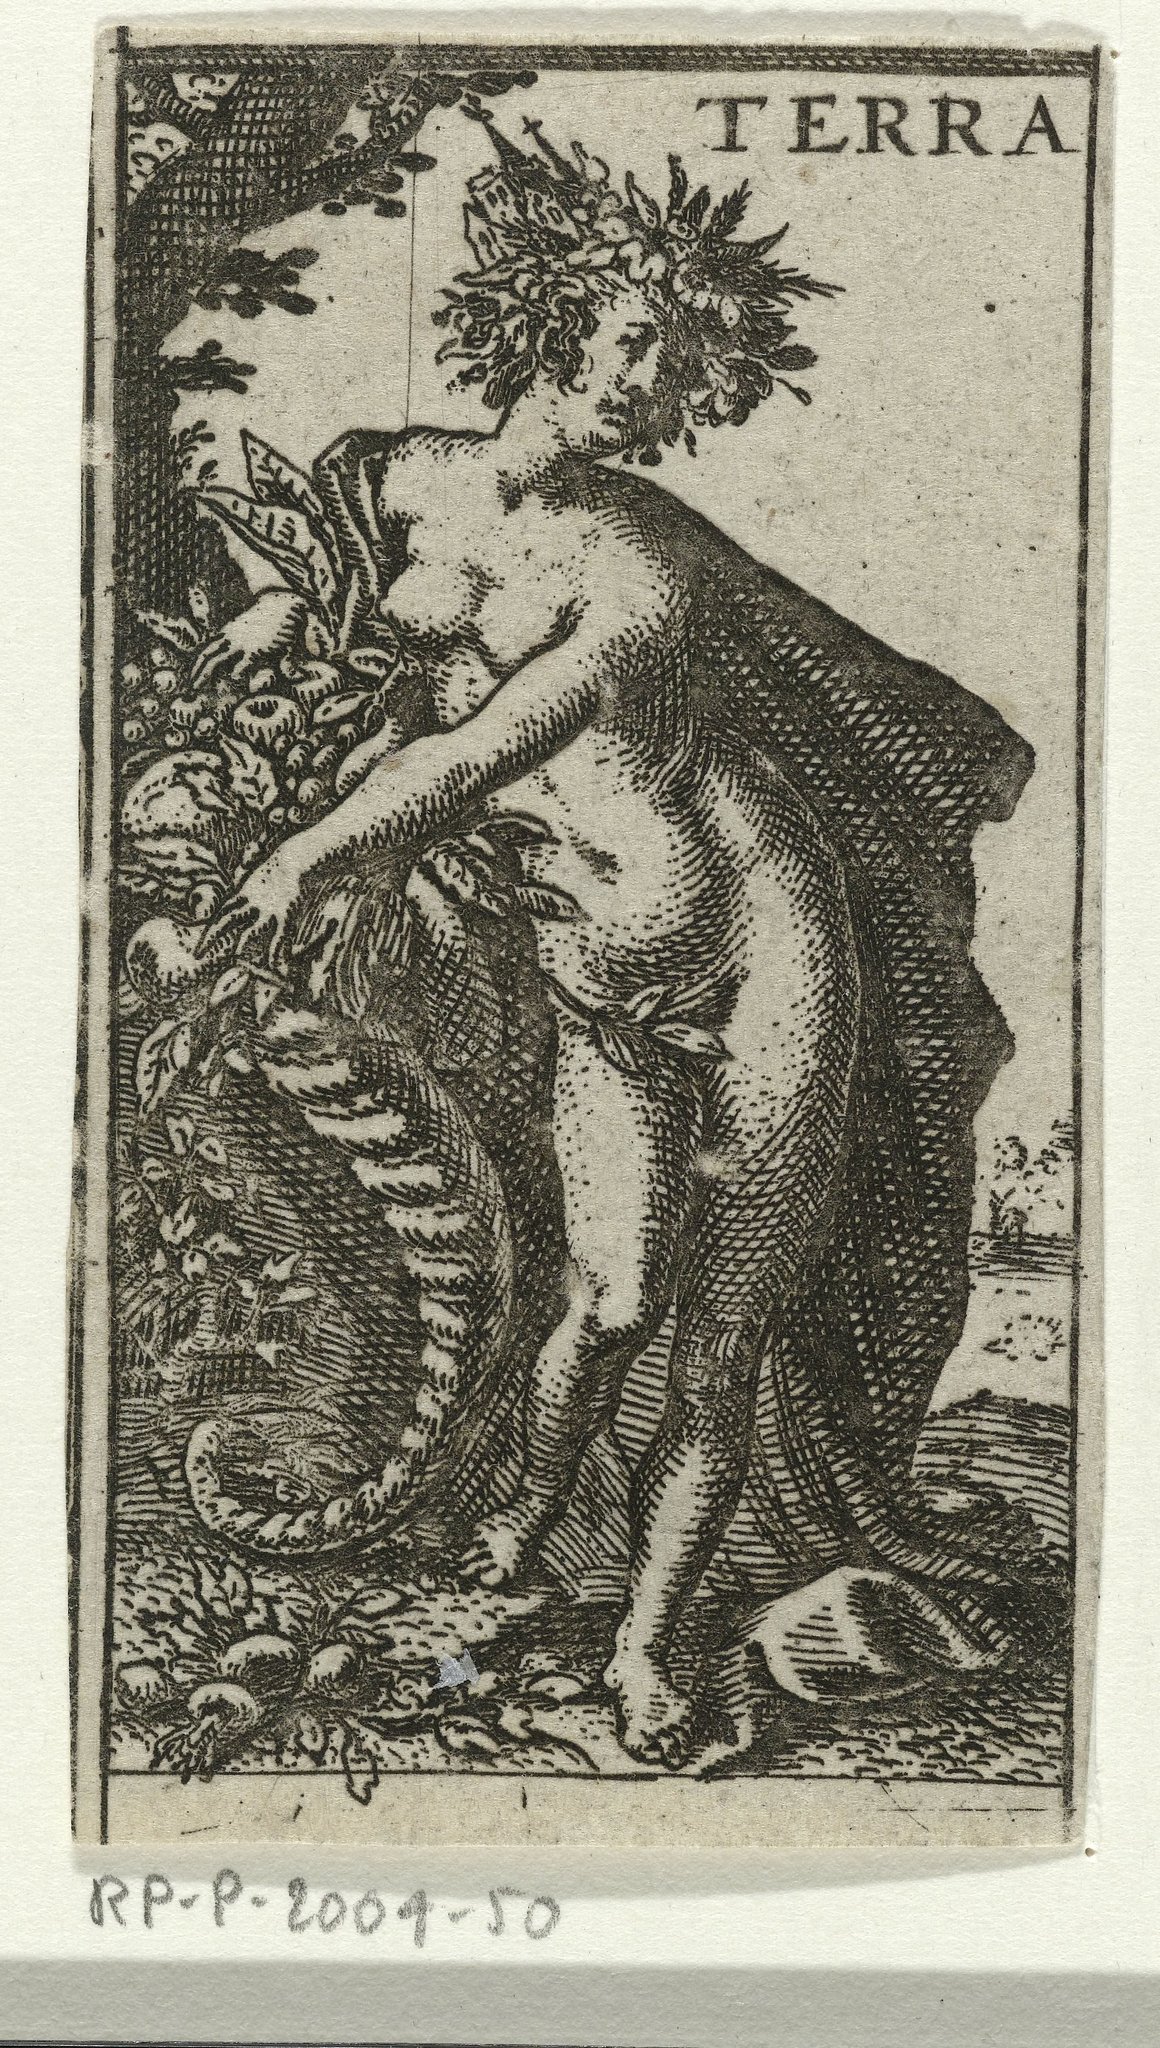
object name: print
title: Aarde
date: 1606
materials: paper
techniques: engraving, etching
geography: amsterdam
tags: 'cornucopia', horn of plenty, 'terra', 'carro della terra' (ripa)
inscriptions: title: ‘TERRA’, collector's mark: Lugt 2228, collector's mark: Lugt 2760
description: Personificatie van aarde, een van de vier elementen, een staande naakte vrouw met hoorn des overvloeds.